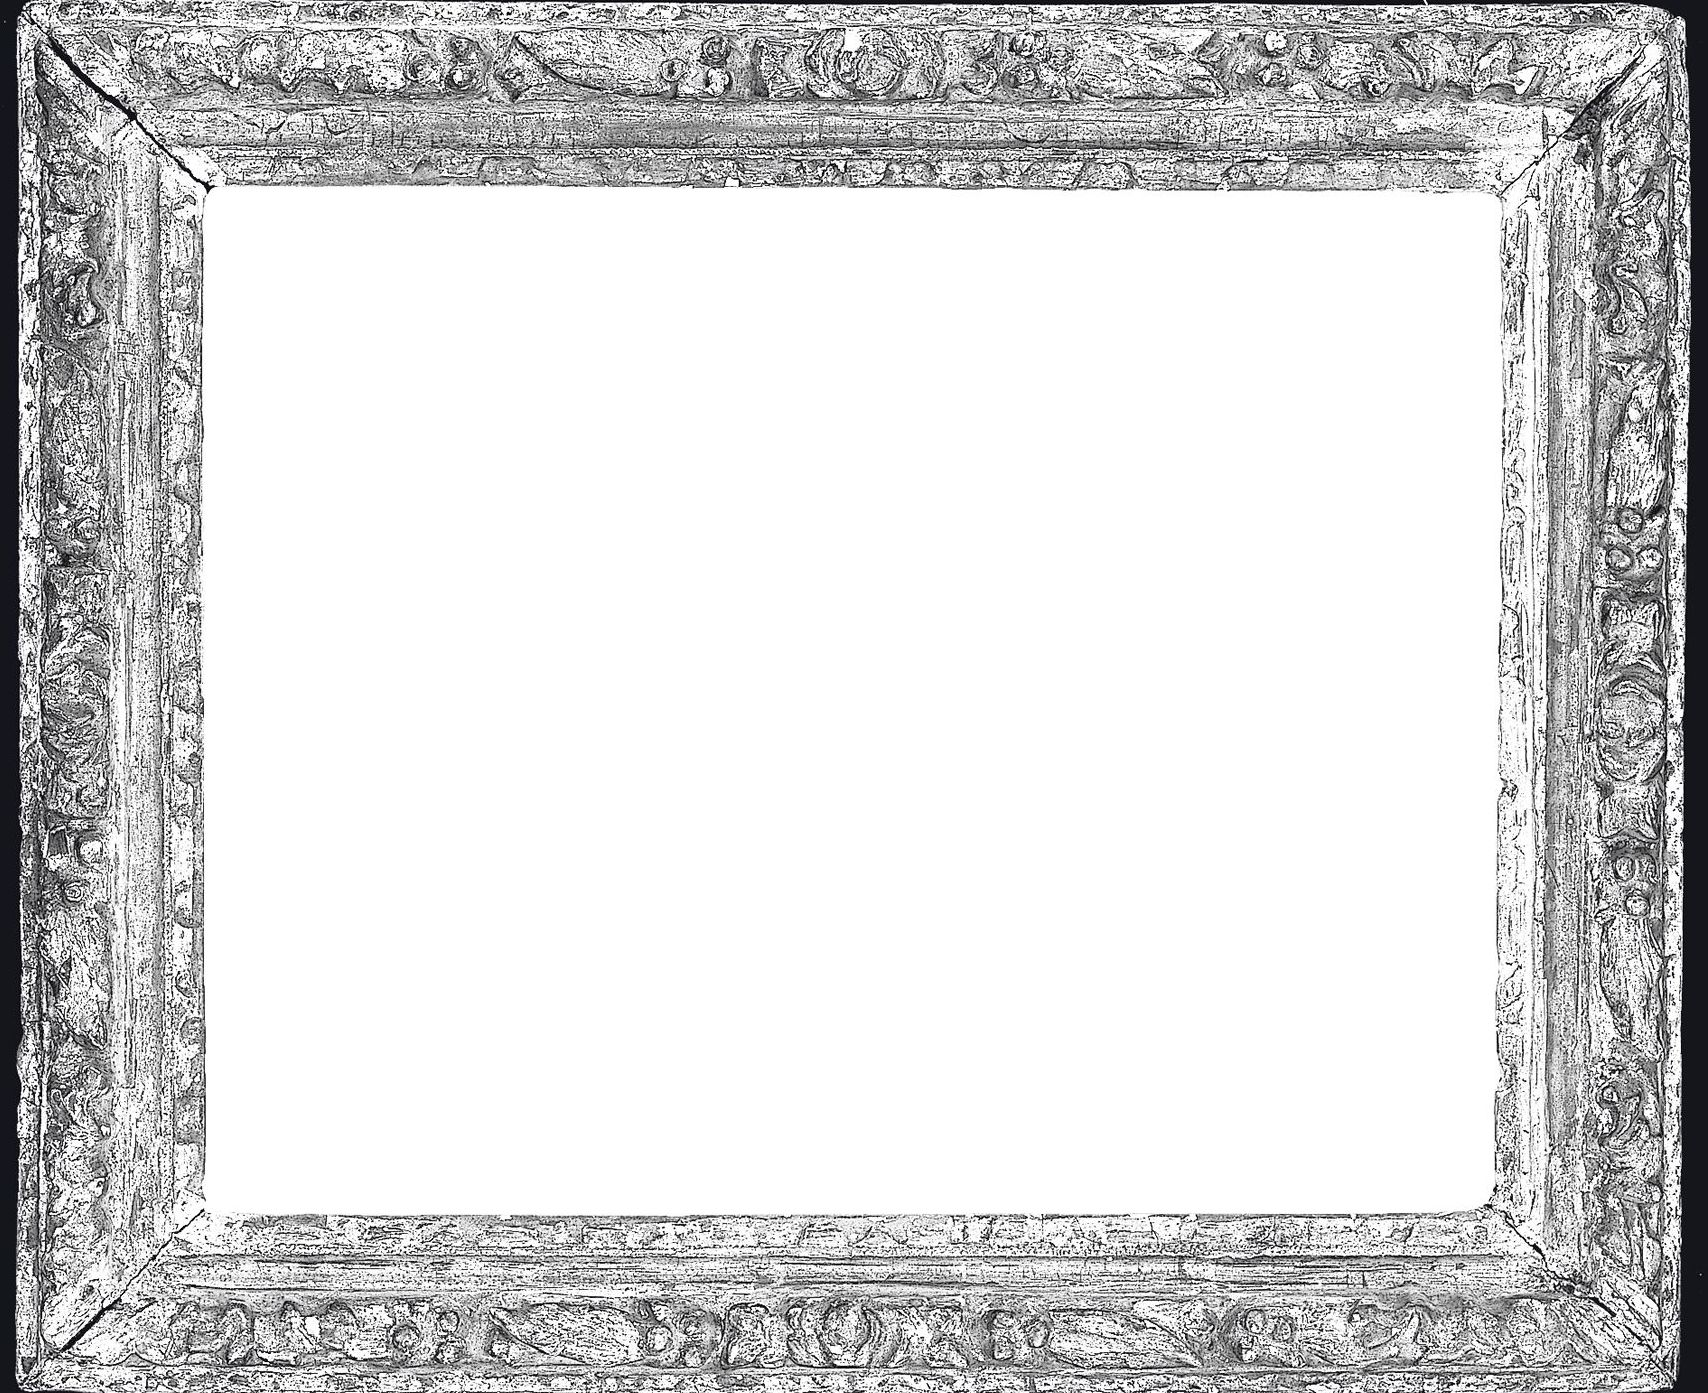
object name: frame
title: Astragal frame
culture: french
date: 1650-1680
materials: wood